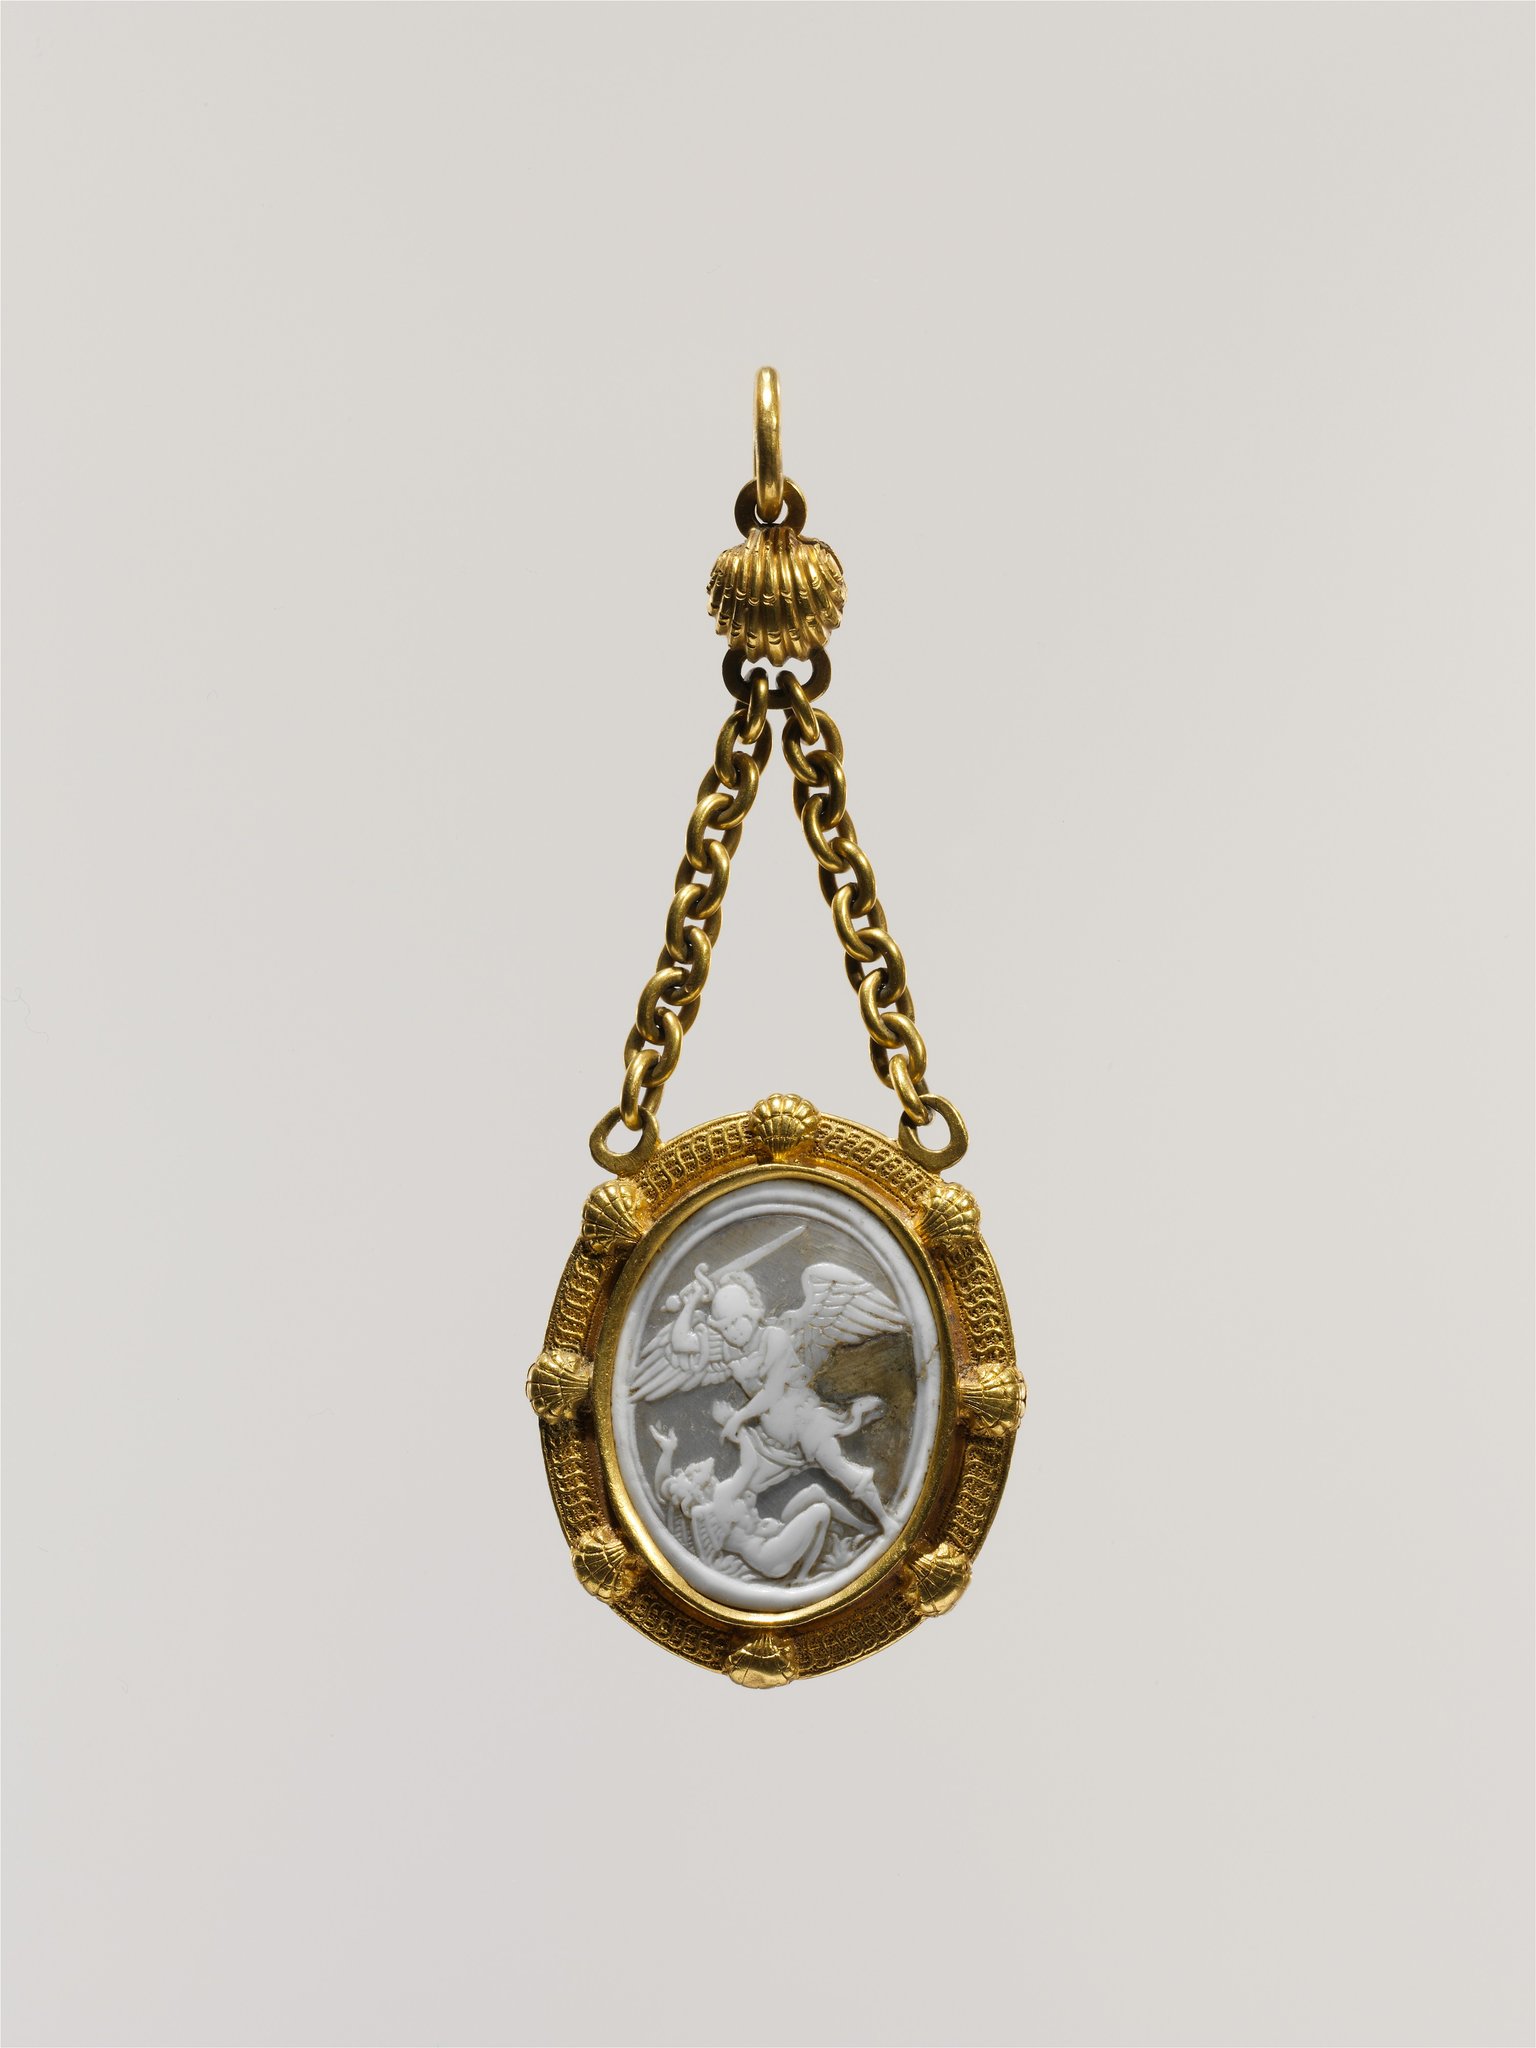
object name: badge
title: Badge of the Order of Saint Michael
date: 1601-1700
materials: gold, shell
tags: saint michael